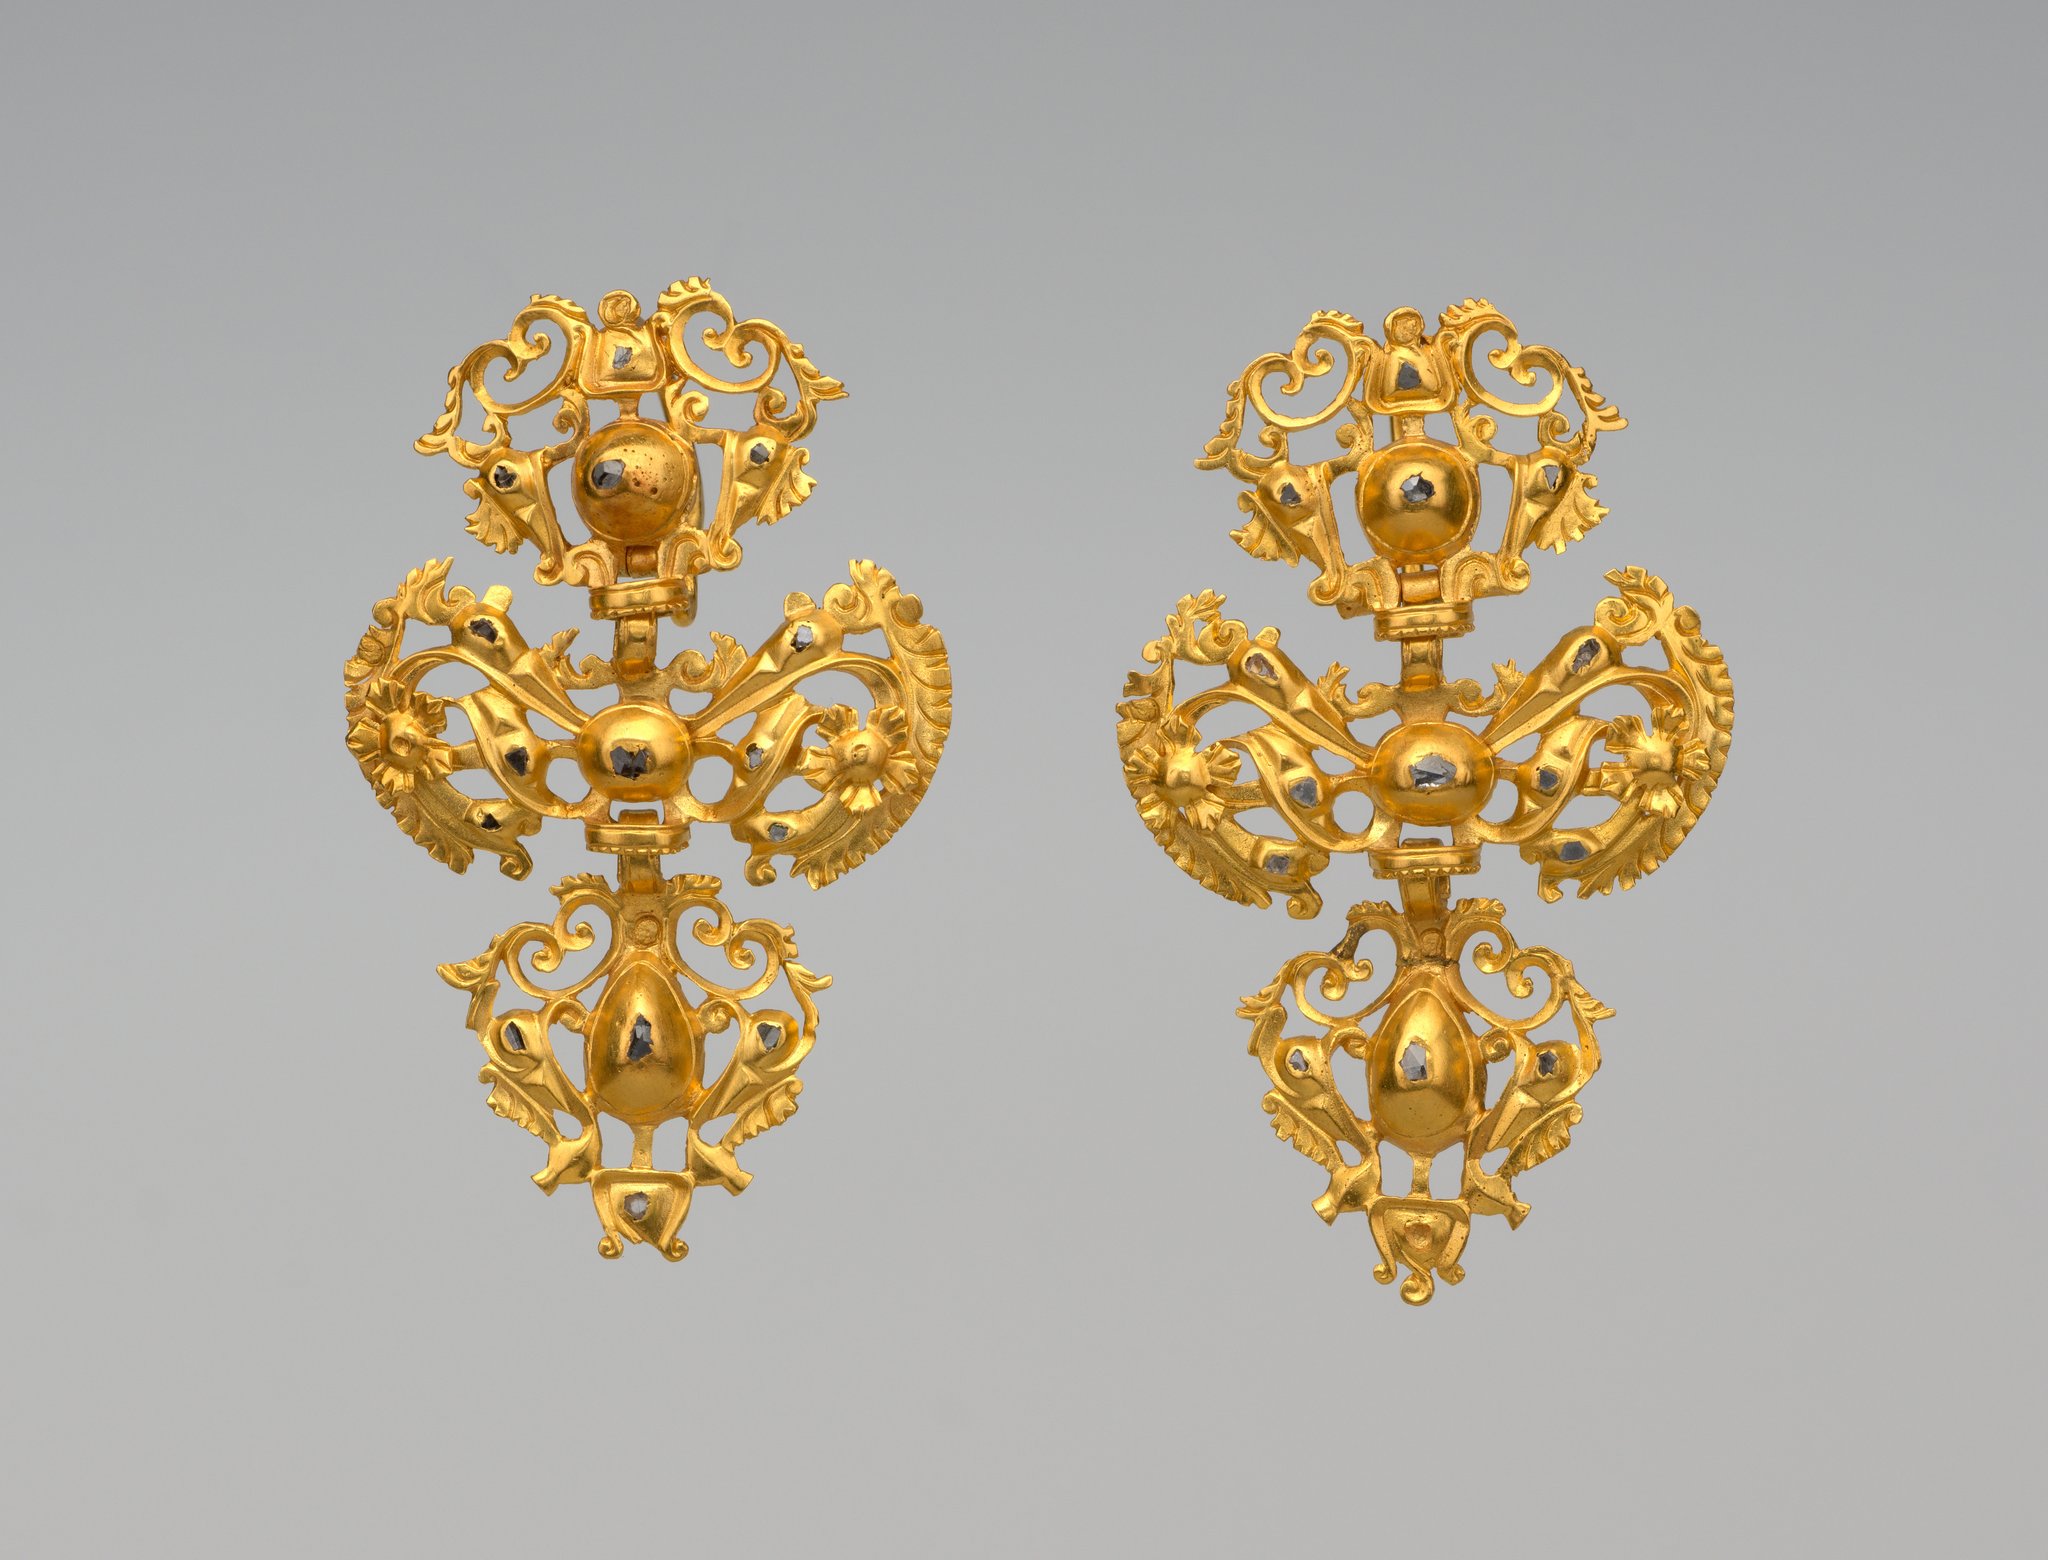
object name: earring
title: Pair of earrings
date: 1701-1800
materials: diamond, gold